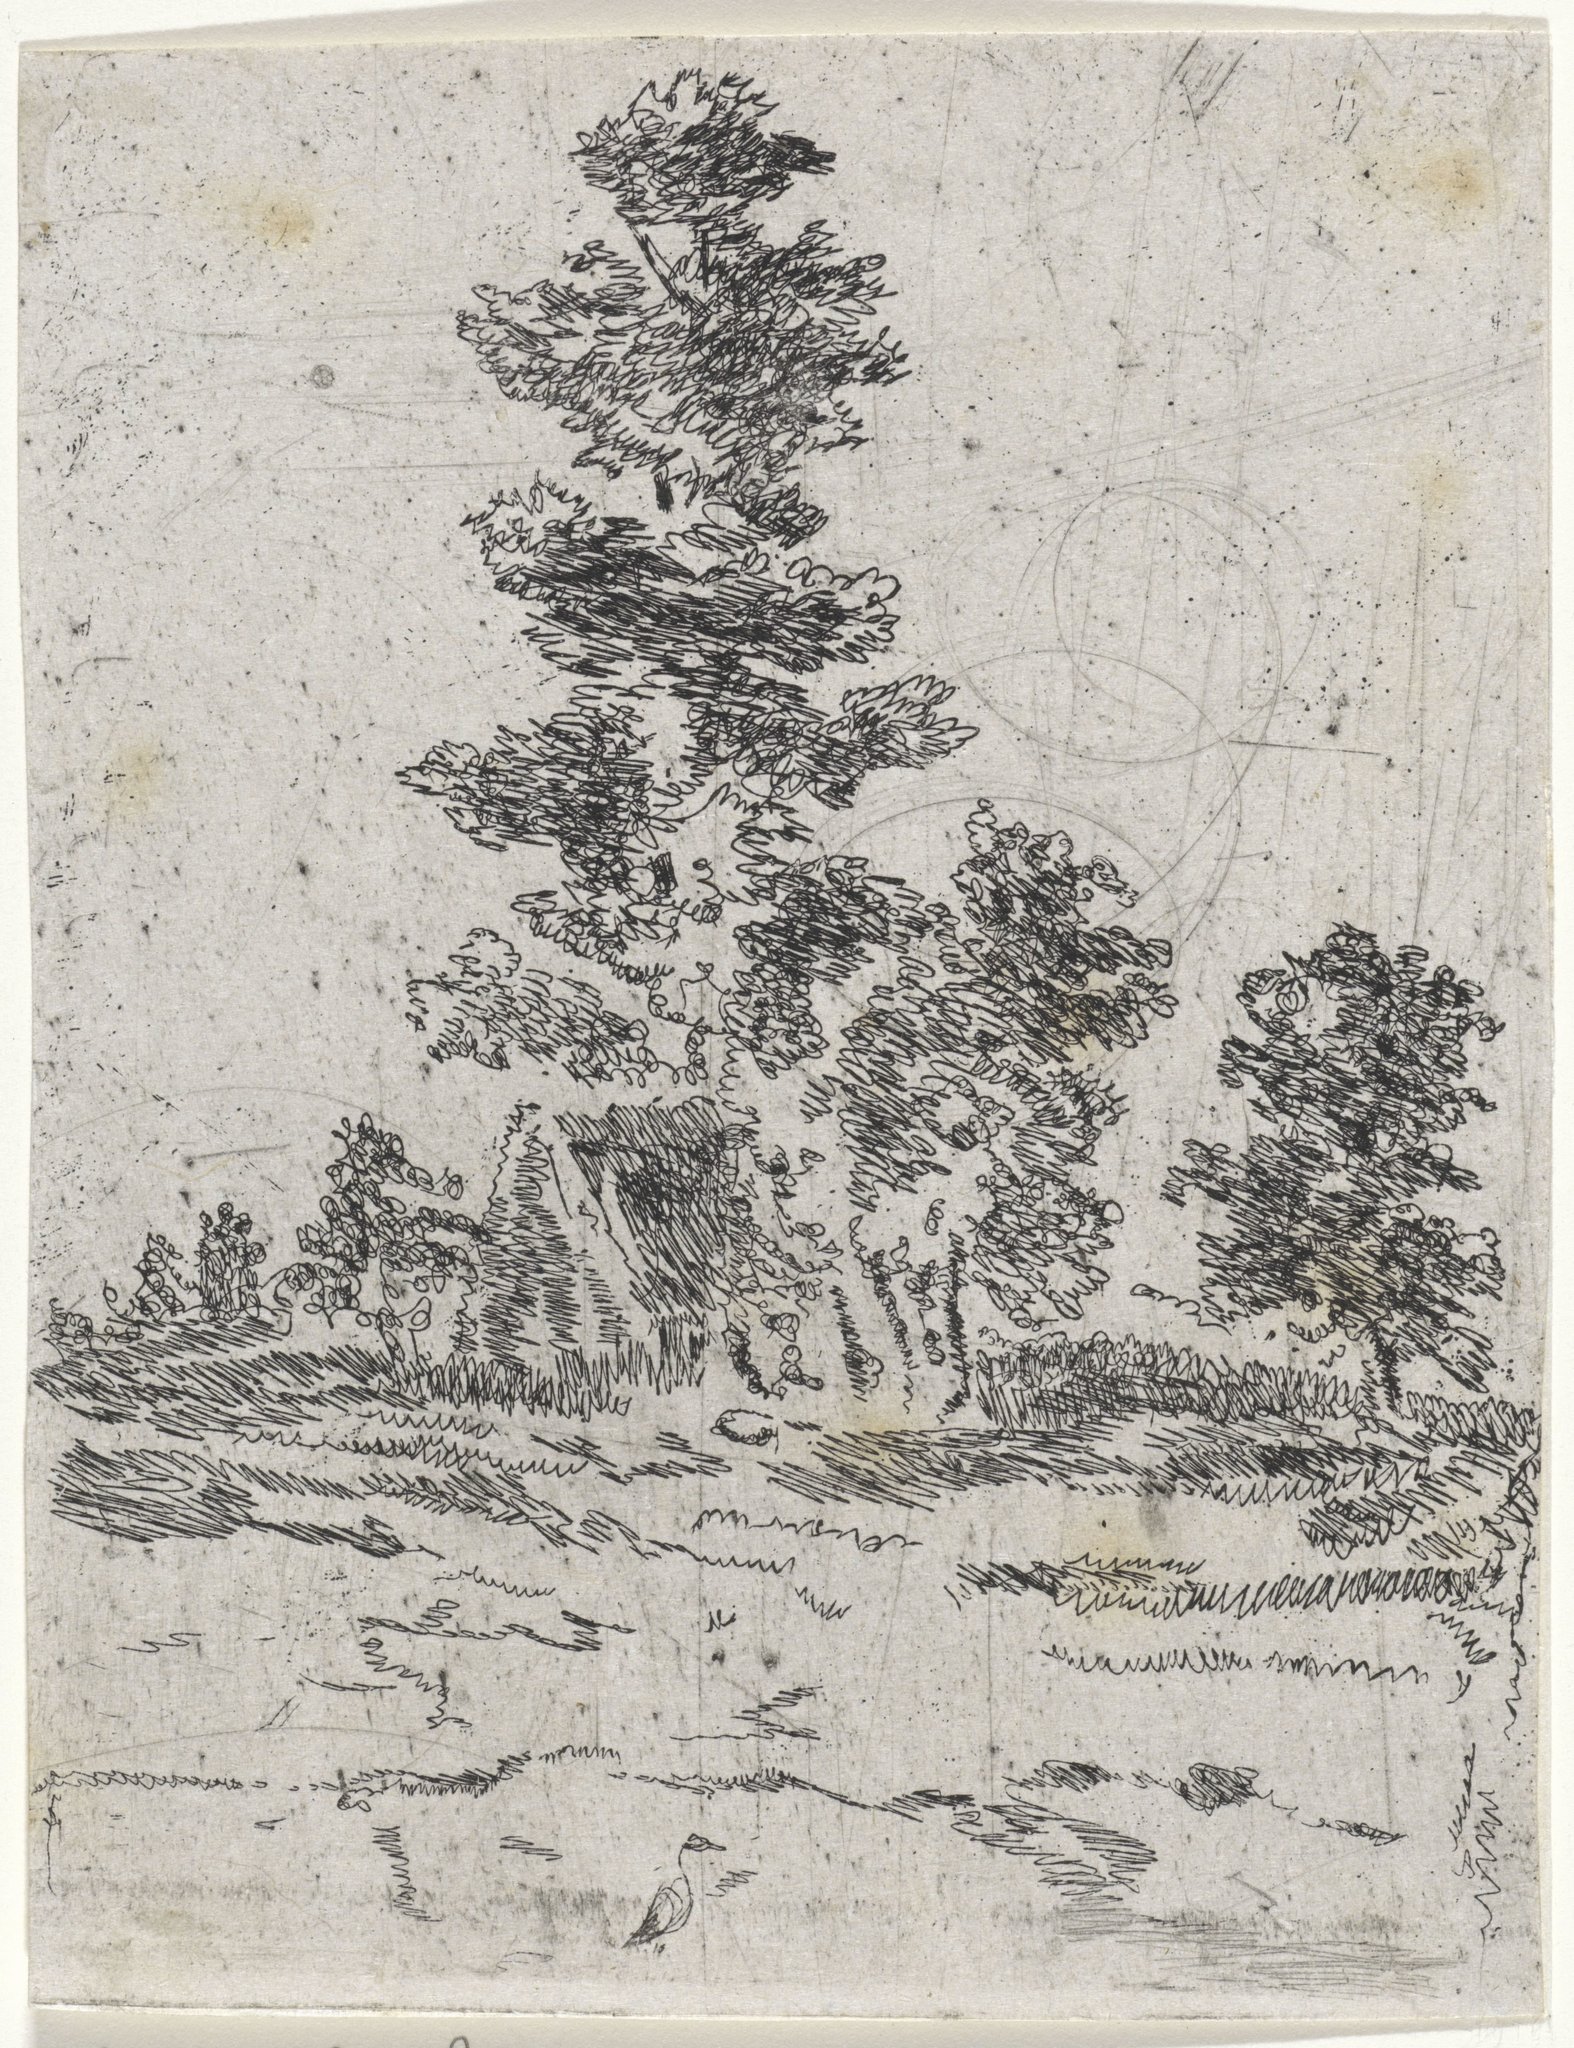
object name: print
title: Landschap met een hut onder bomen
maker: arnoud schaepkens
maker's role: print maker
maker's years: 1816-1904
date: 1831-1904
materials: paper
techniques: etching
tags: trees, landscapes in the temperate zone, cottage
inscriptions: collector's mark: Lugt 2228